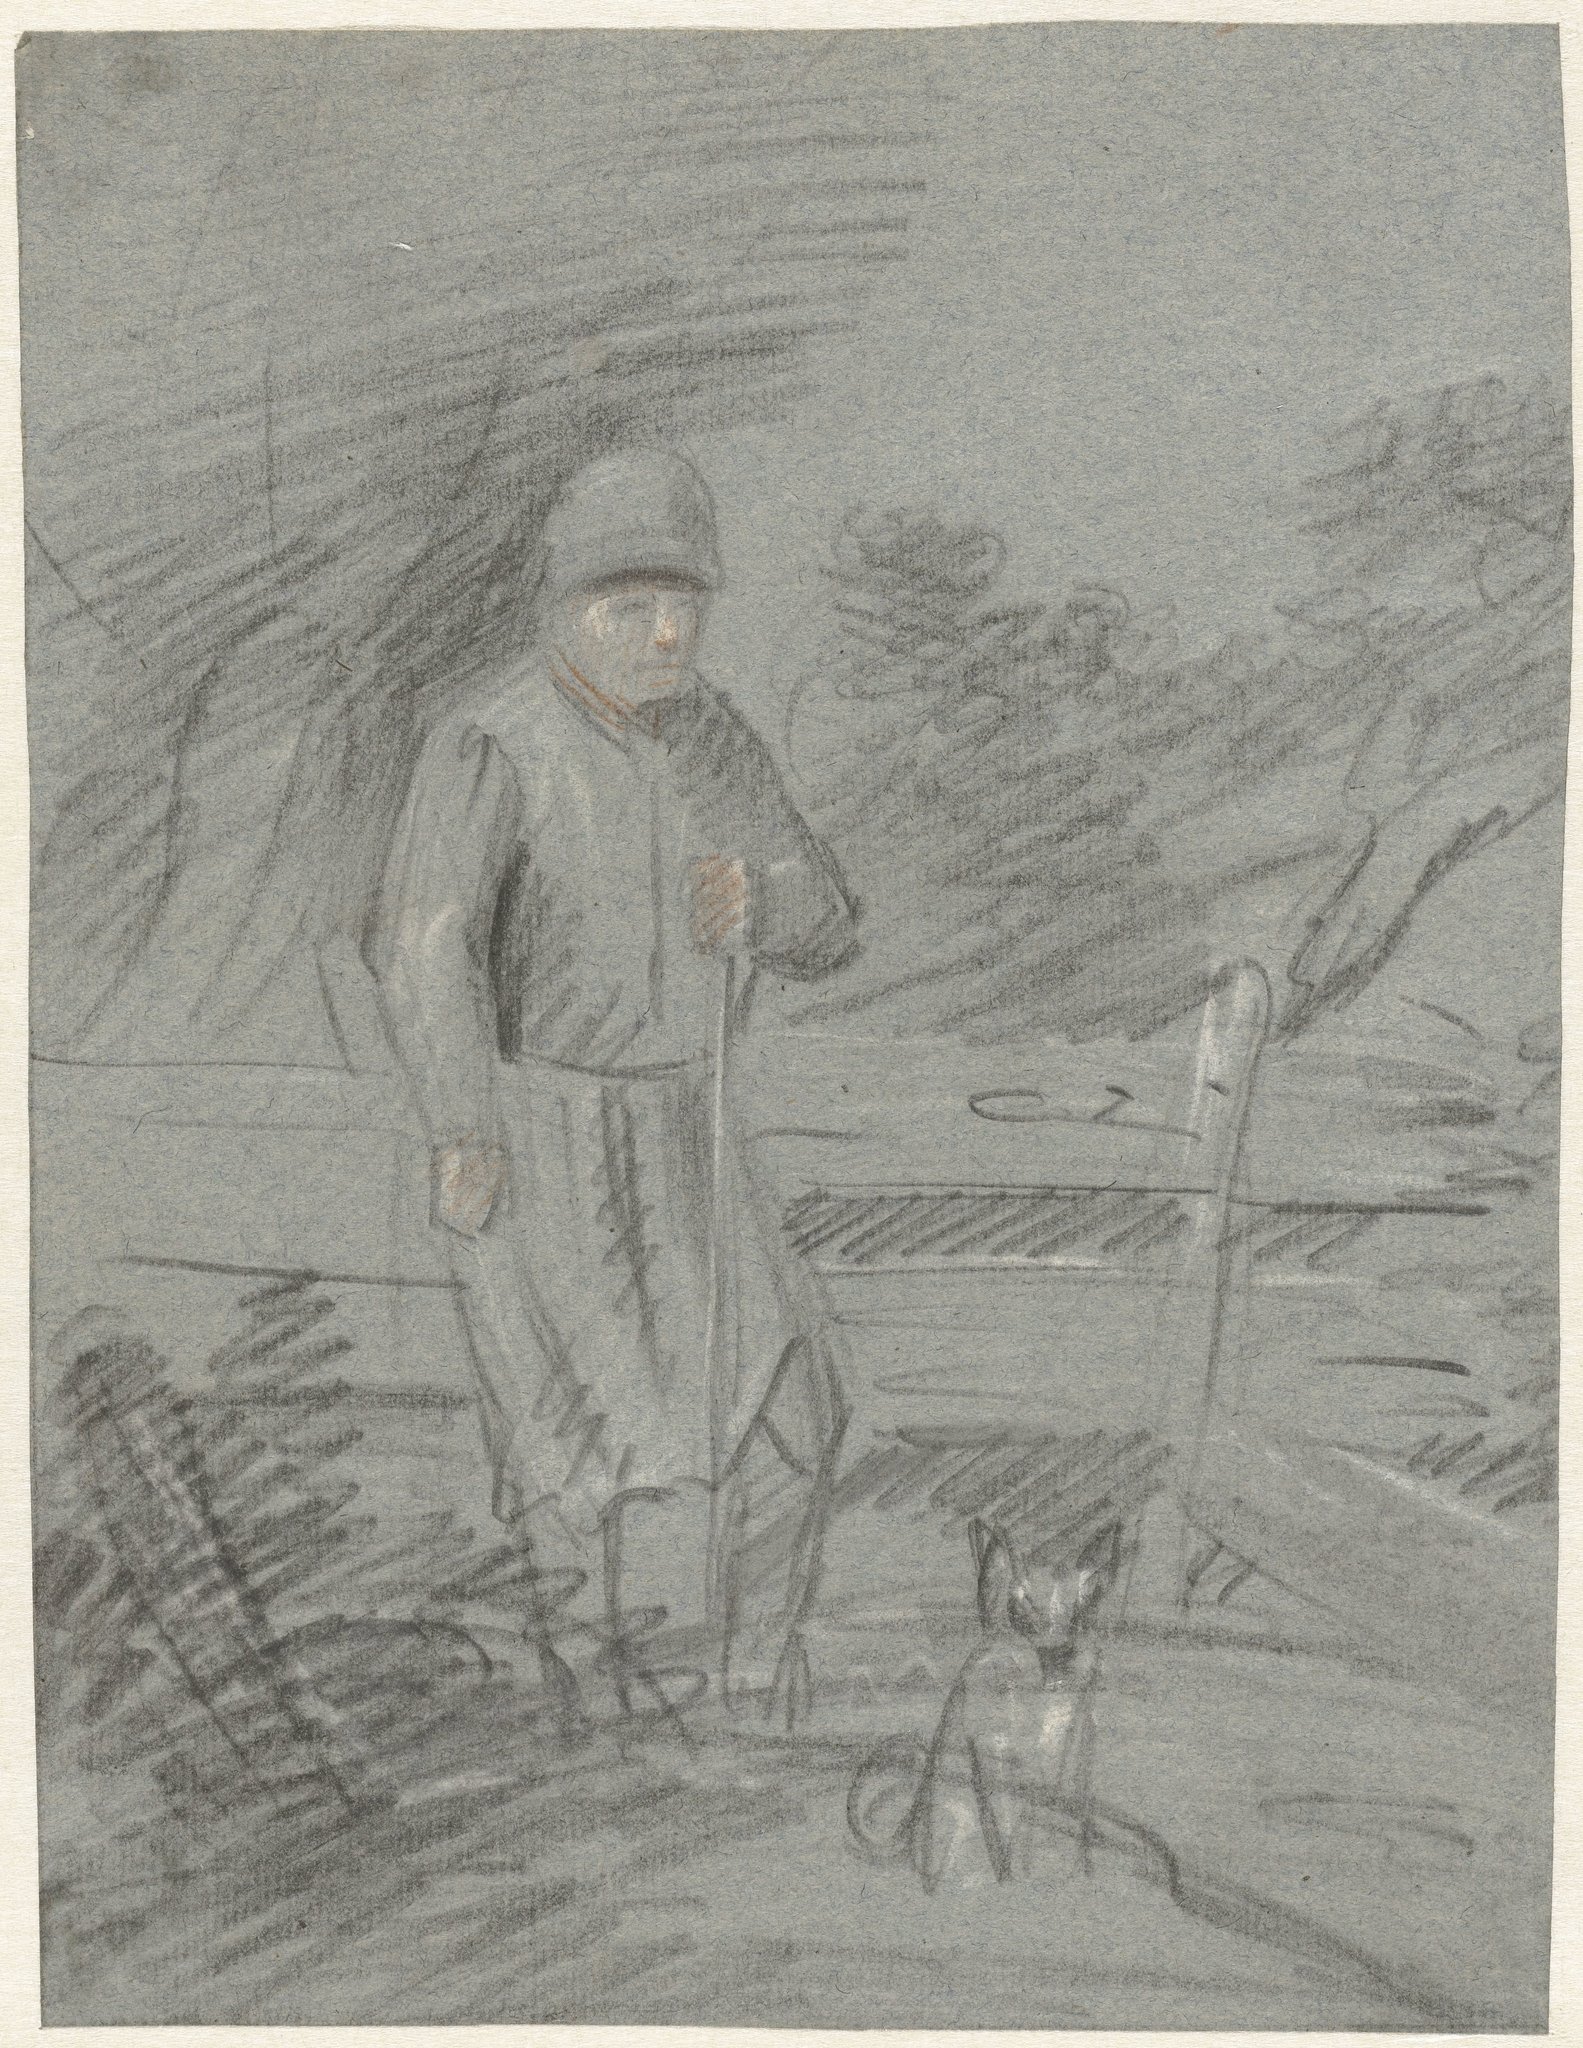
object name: drawing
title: Staande herder met zijn hond, bij een omheining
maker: simon andreas krausz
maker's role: draughtsman, print maker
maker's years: 1760-1825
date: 1770-1825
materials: chalk, paper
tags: dog